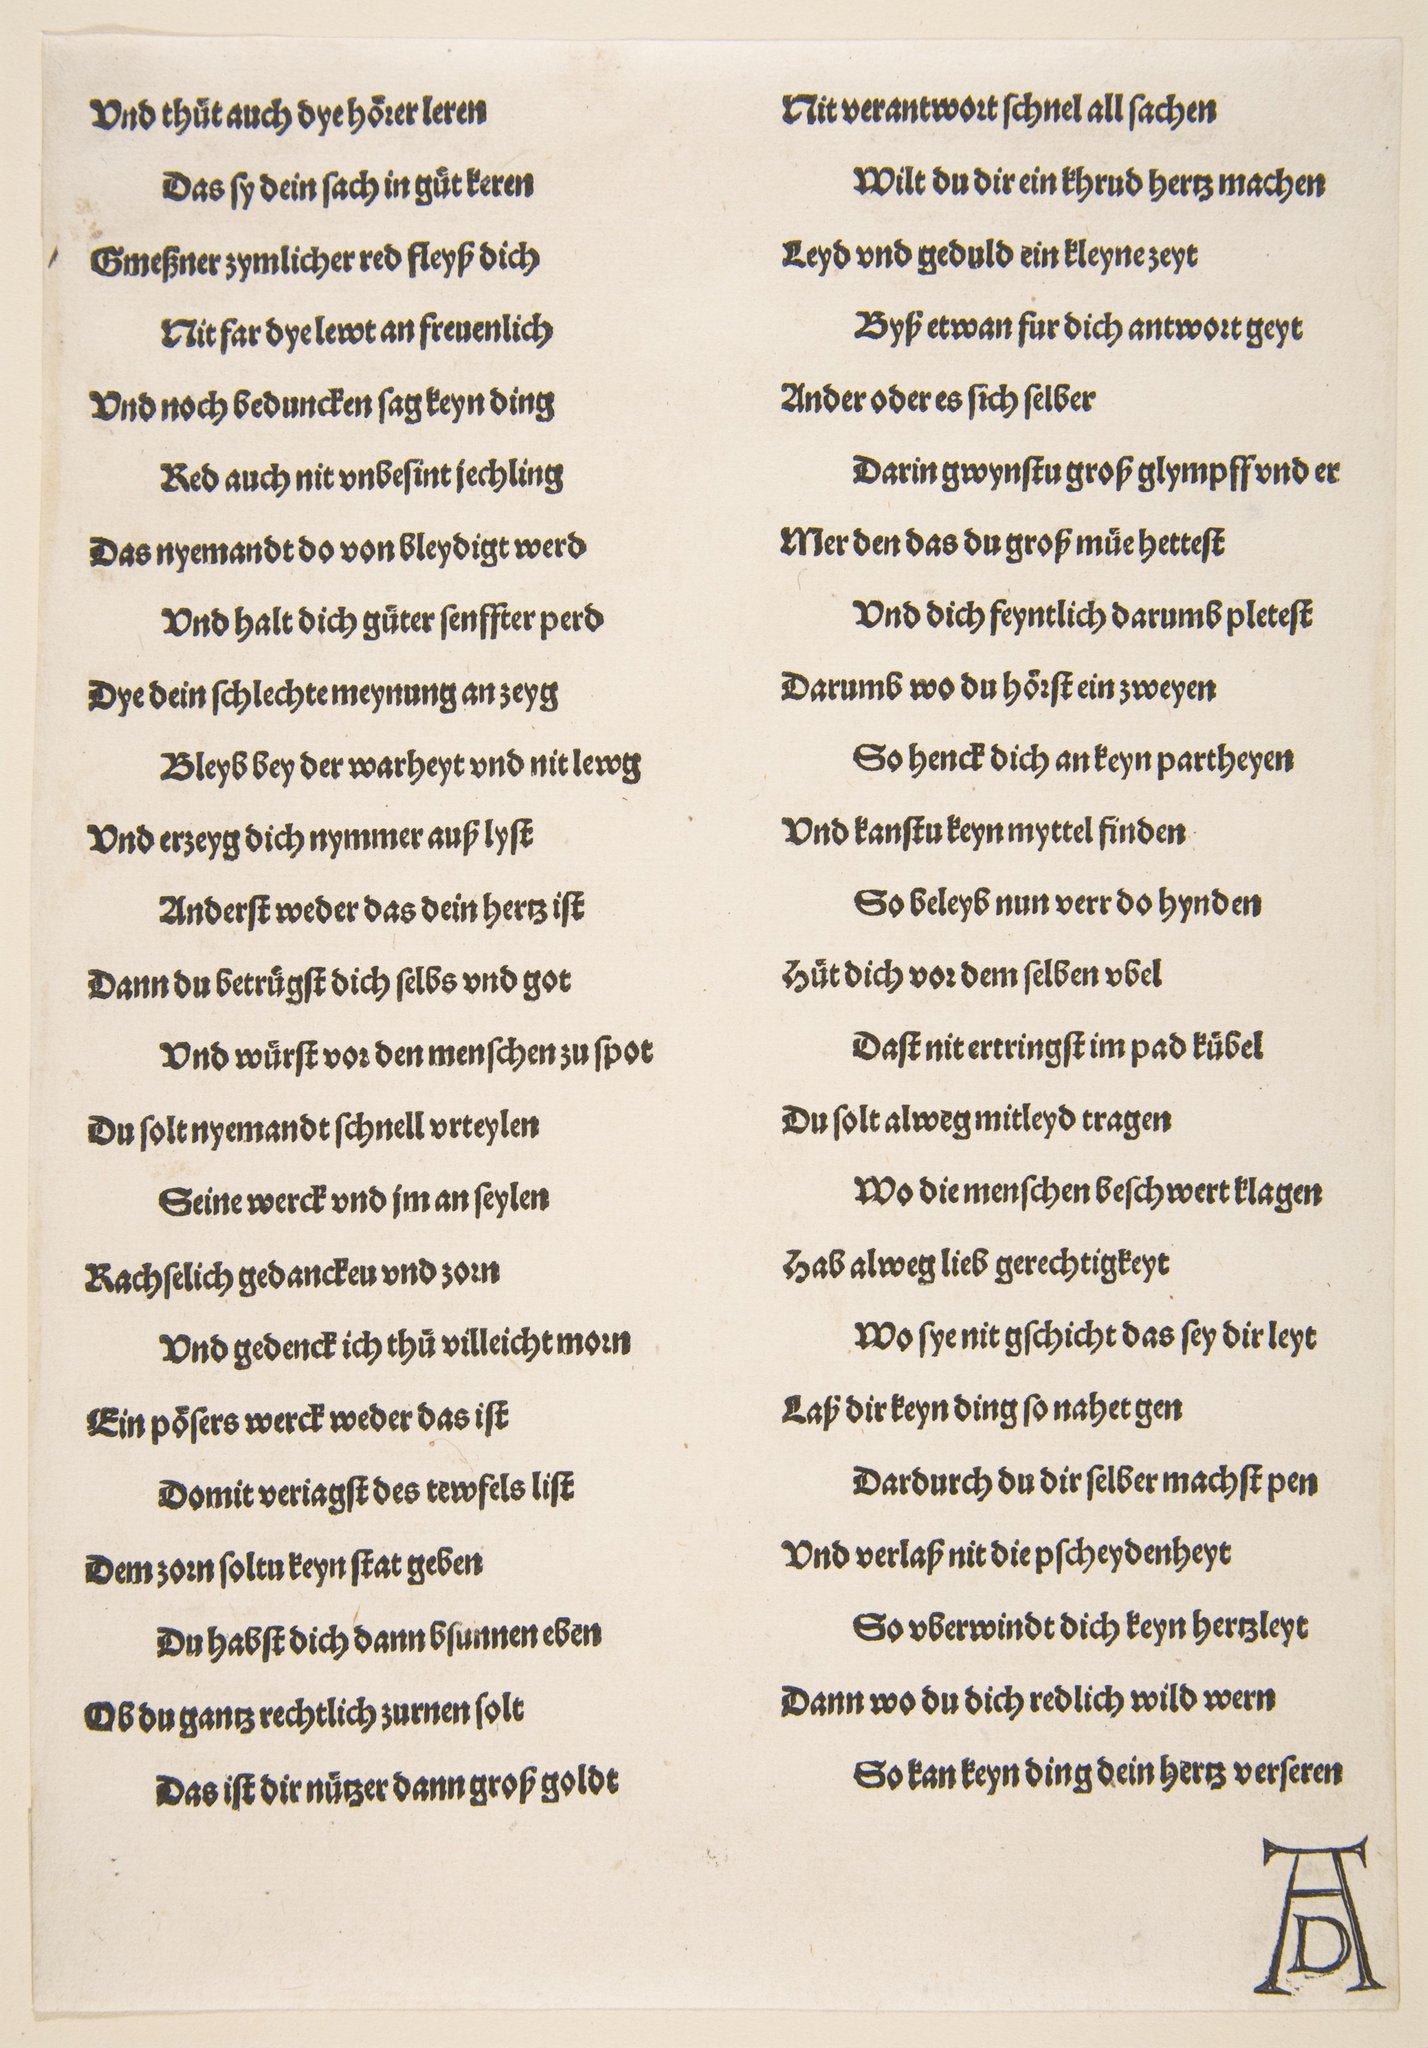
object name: print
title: The Schoolmaster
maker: albrecht dürer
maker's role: artist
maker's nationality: german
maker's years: 1471-1528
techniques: woodcut